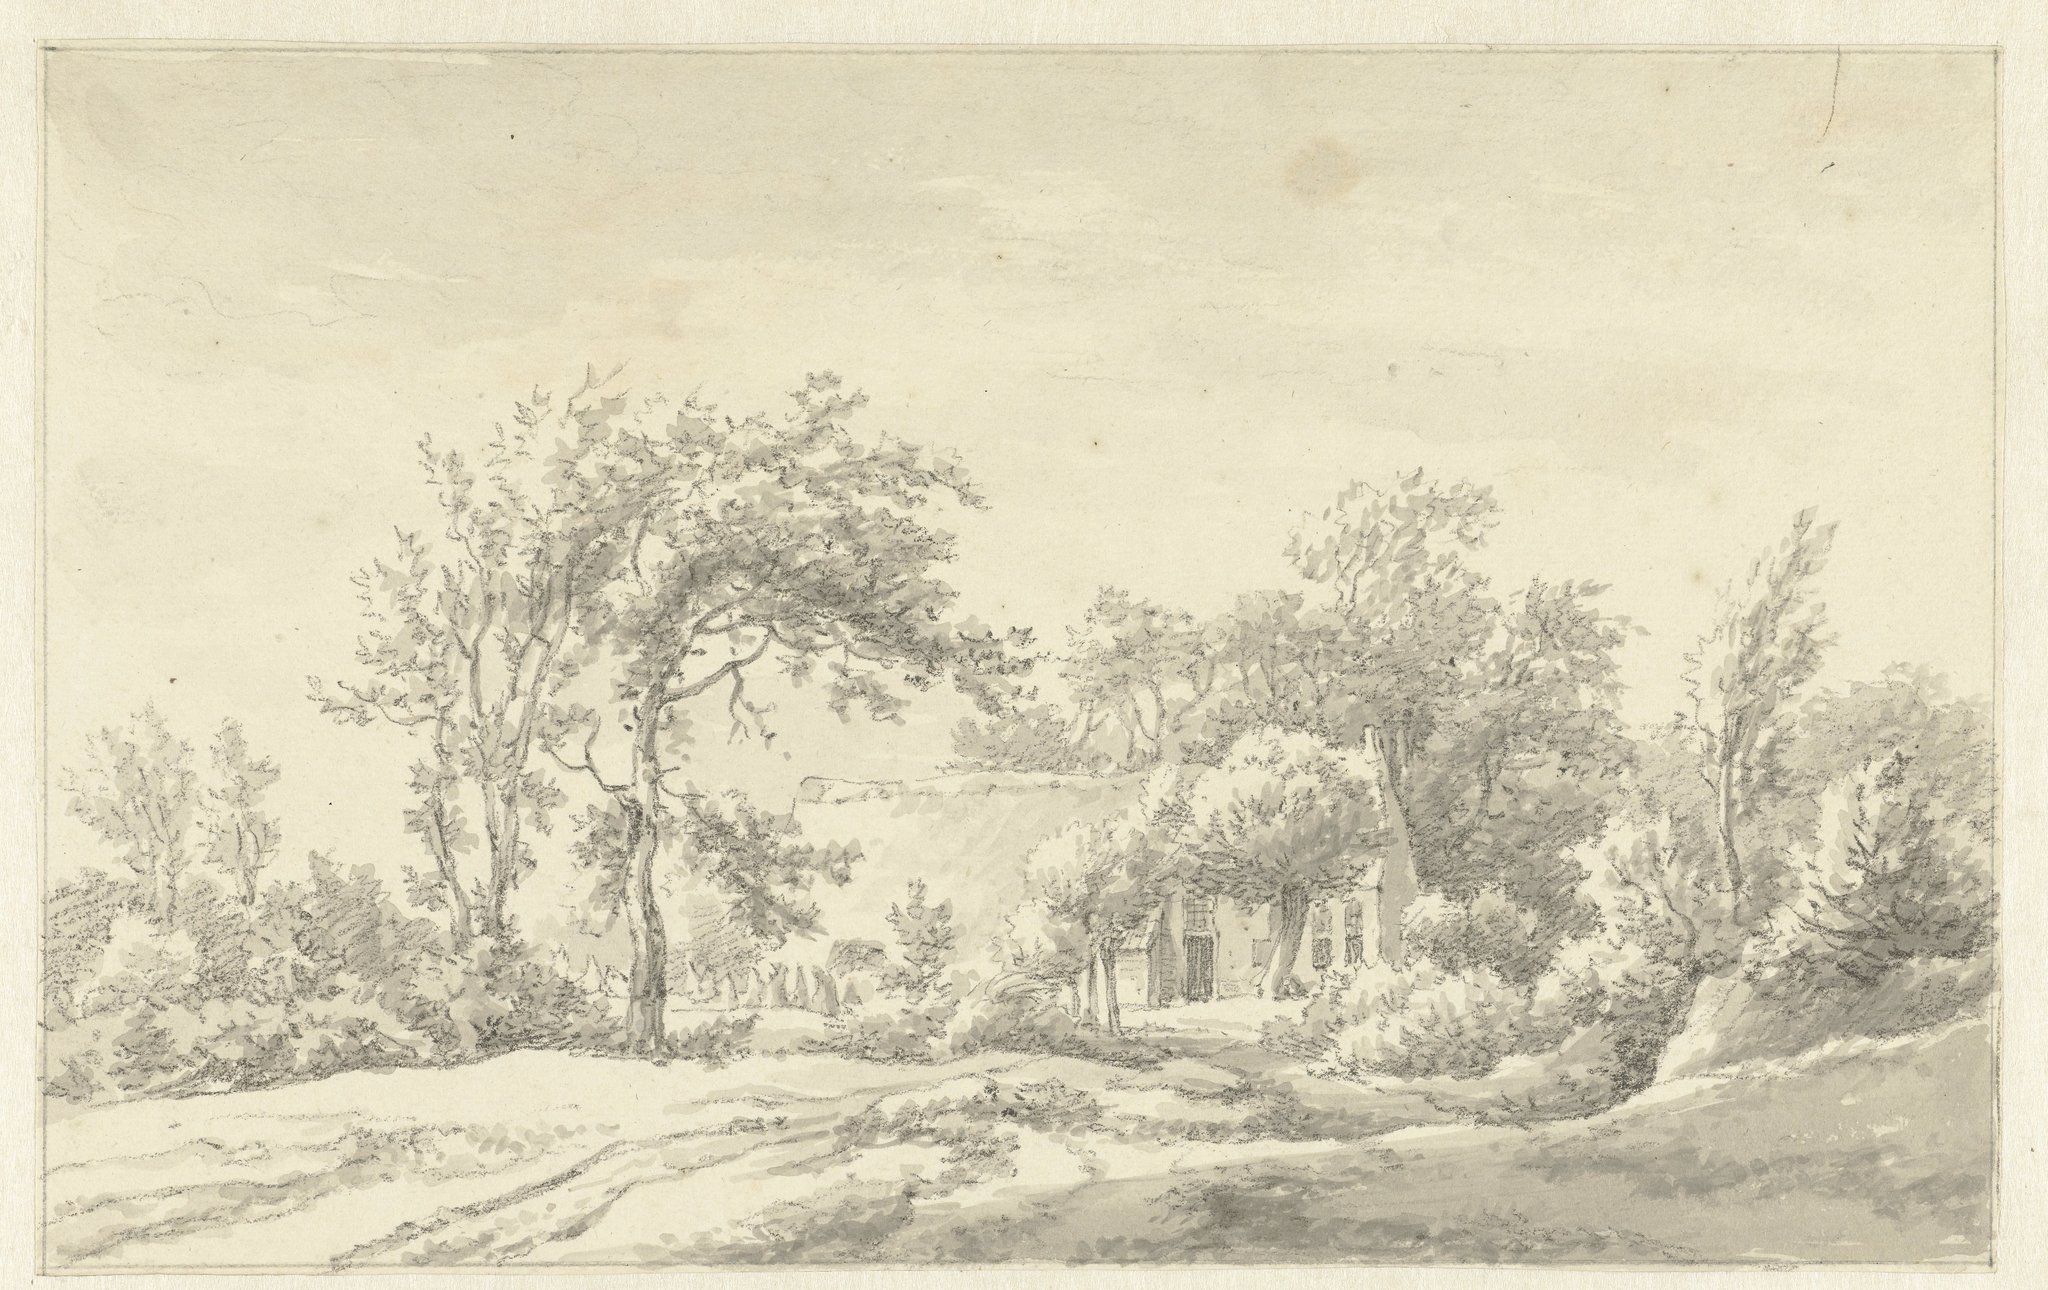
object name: drawing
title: Boerderij te Midlaren in Drenthe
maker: egbert van drielst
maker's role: draughtsman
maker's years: 1745-1818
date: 1755-1818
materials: chalk, paper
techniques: brush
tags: farm (building)